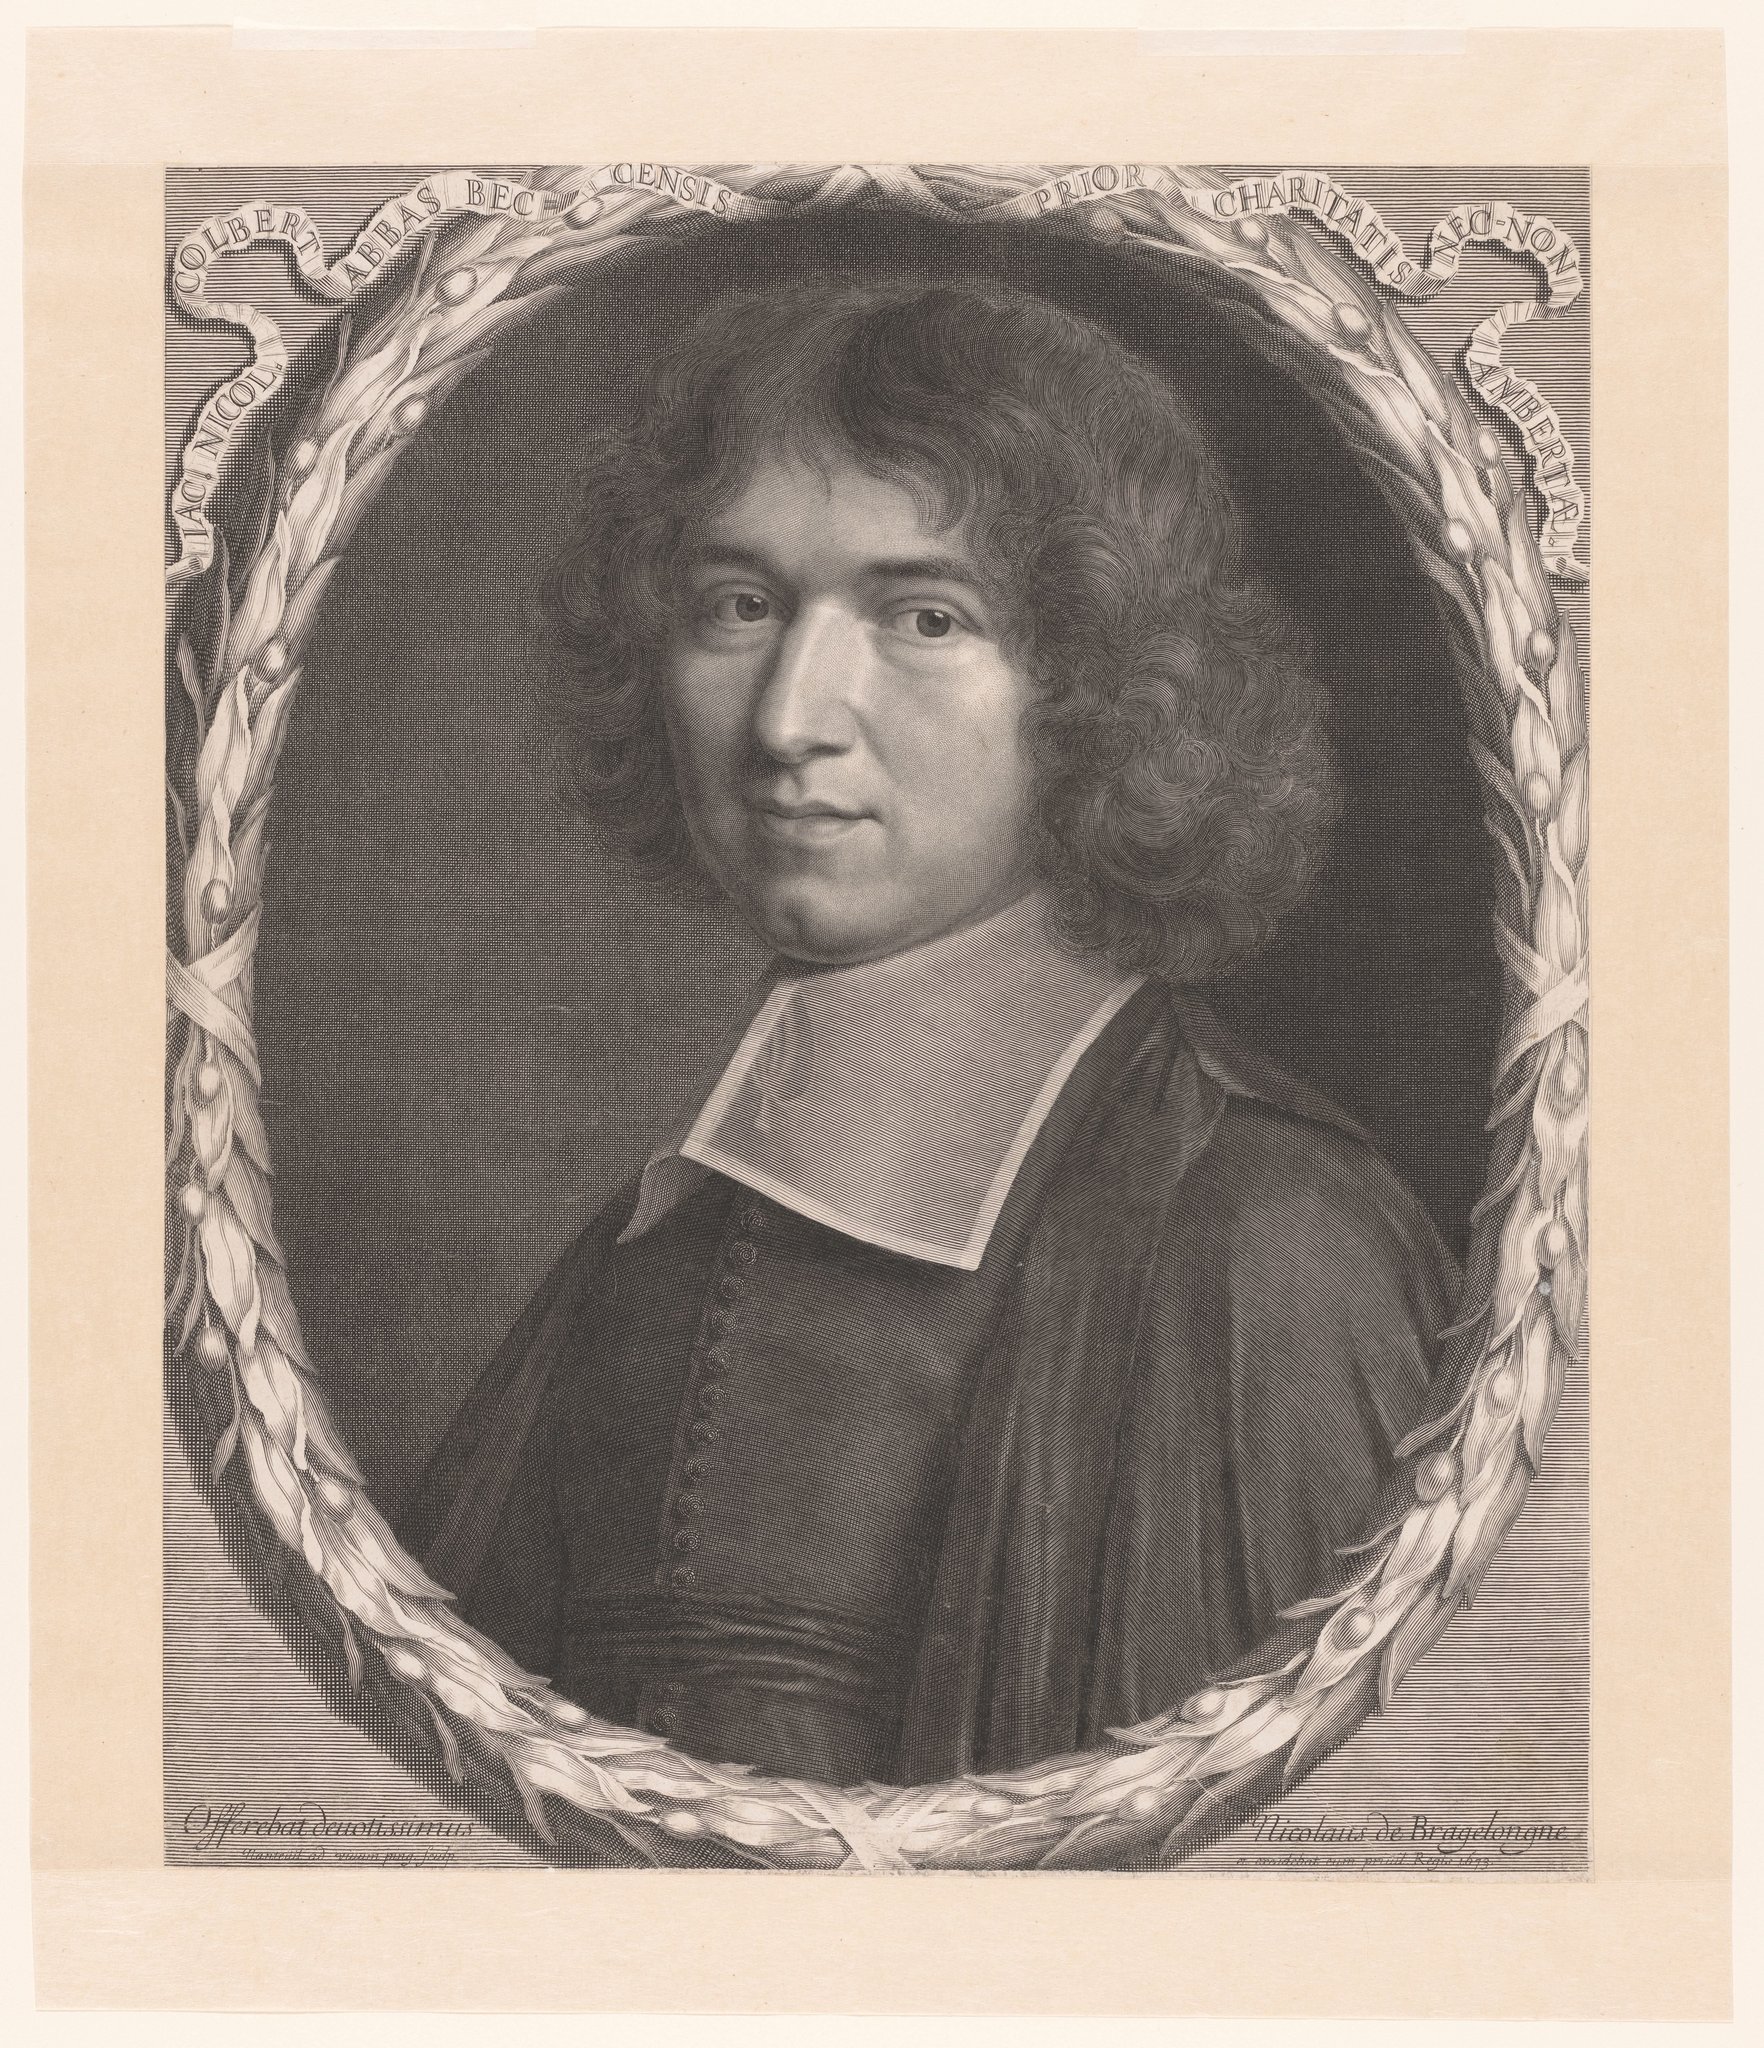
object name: print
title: Iac. Nicol. Colbert (...)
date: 1673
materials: paper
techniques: engraving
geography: france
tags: paris, jacques-nicolas colbert, archbishop, bishop, etc. (roman catholic), historical persons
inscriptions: collector's mark: Lugt 12